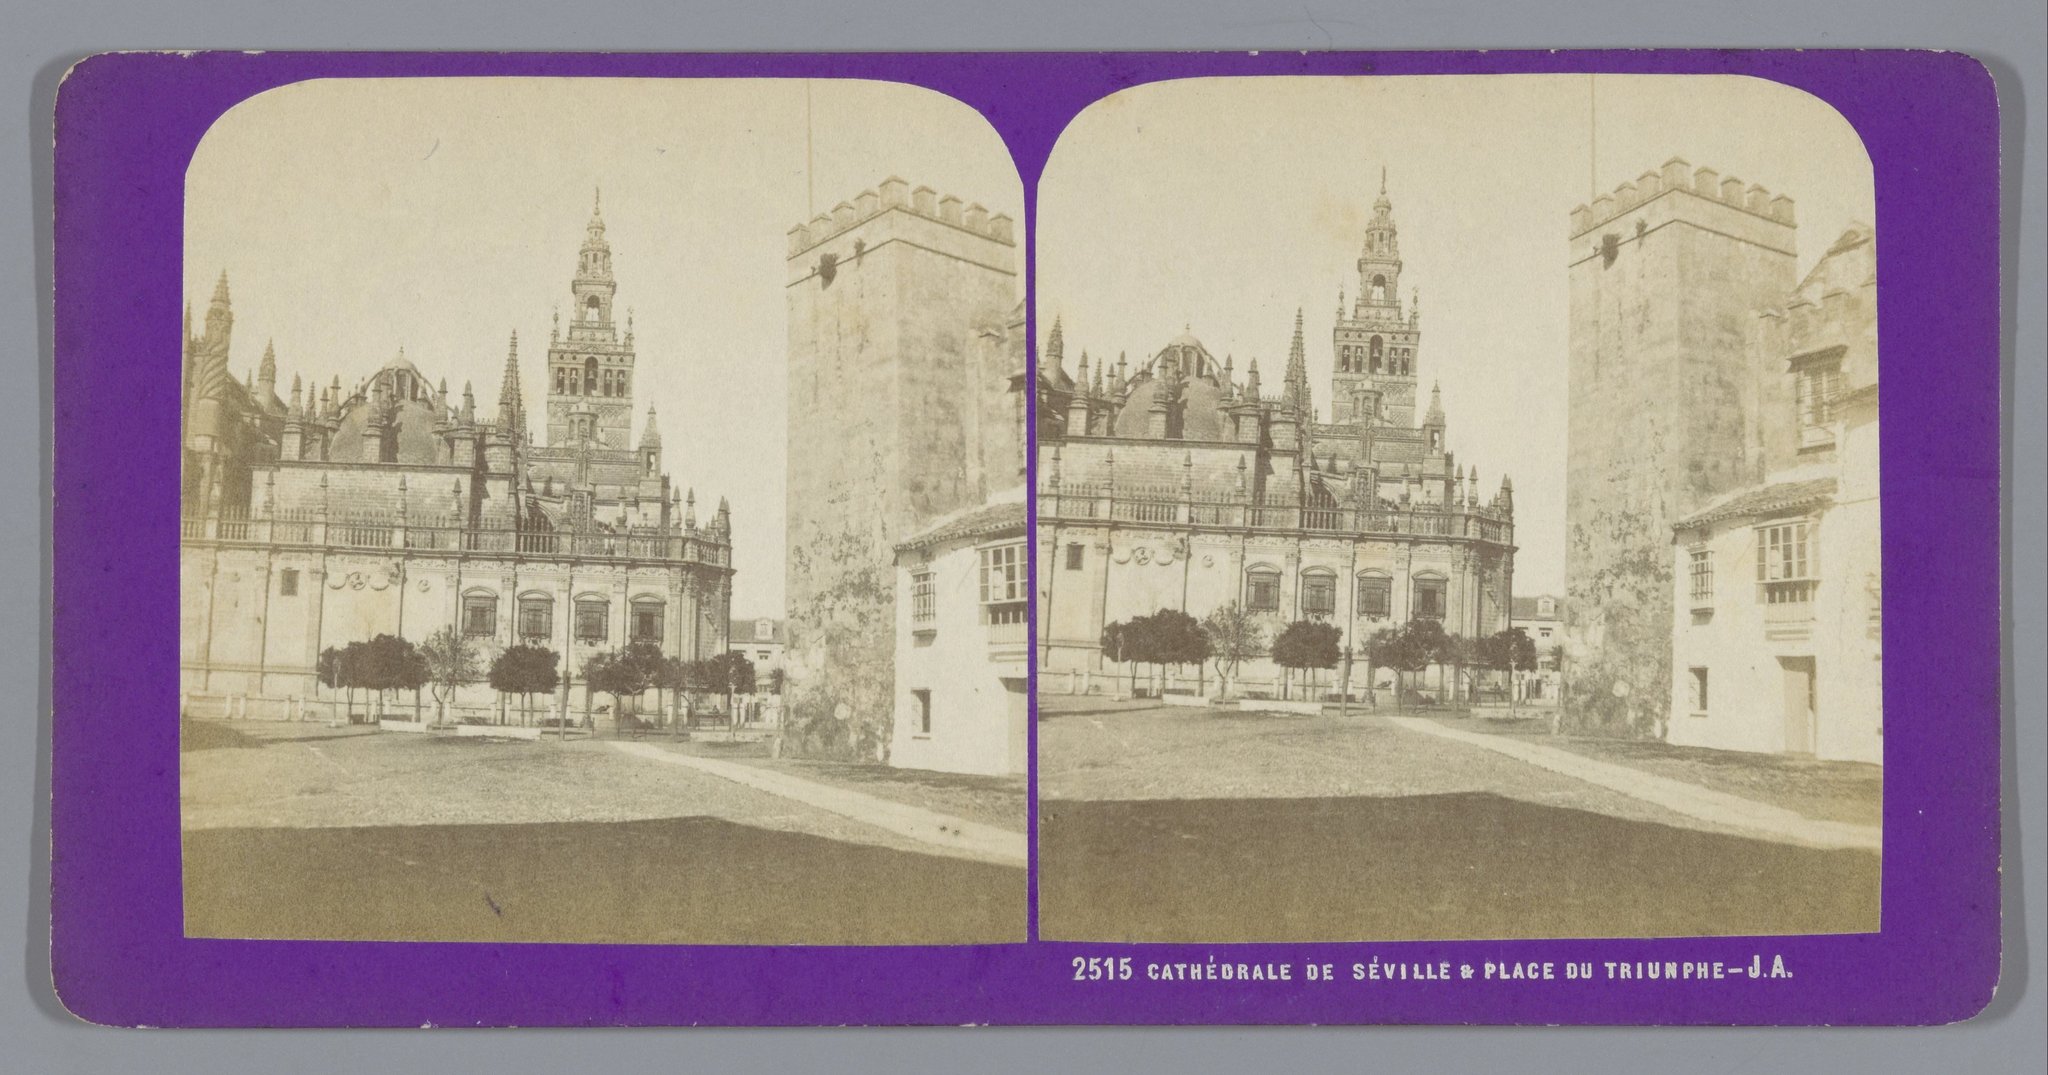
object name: stereograph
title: Gezicht op de Kathedraal van Sevilla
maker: jean andrieu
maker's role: fotograaf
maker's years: 1816-1872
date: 1862-1876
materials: cardboard, photographic support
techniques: albumen print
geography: sevilla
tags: church (exterior), façade (of house or building)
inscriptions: number: ‘2515’